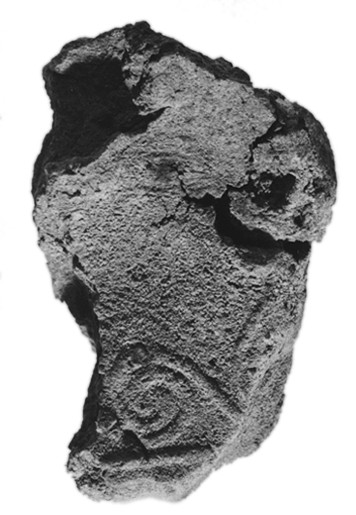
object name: sealing fragment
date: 2030-1640 BCE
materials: clay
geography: egypt